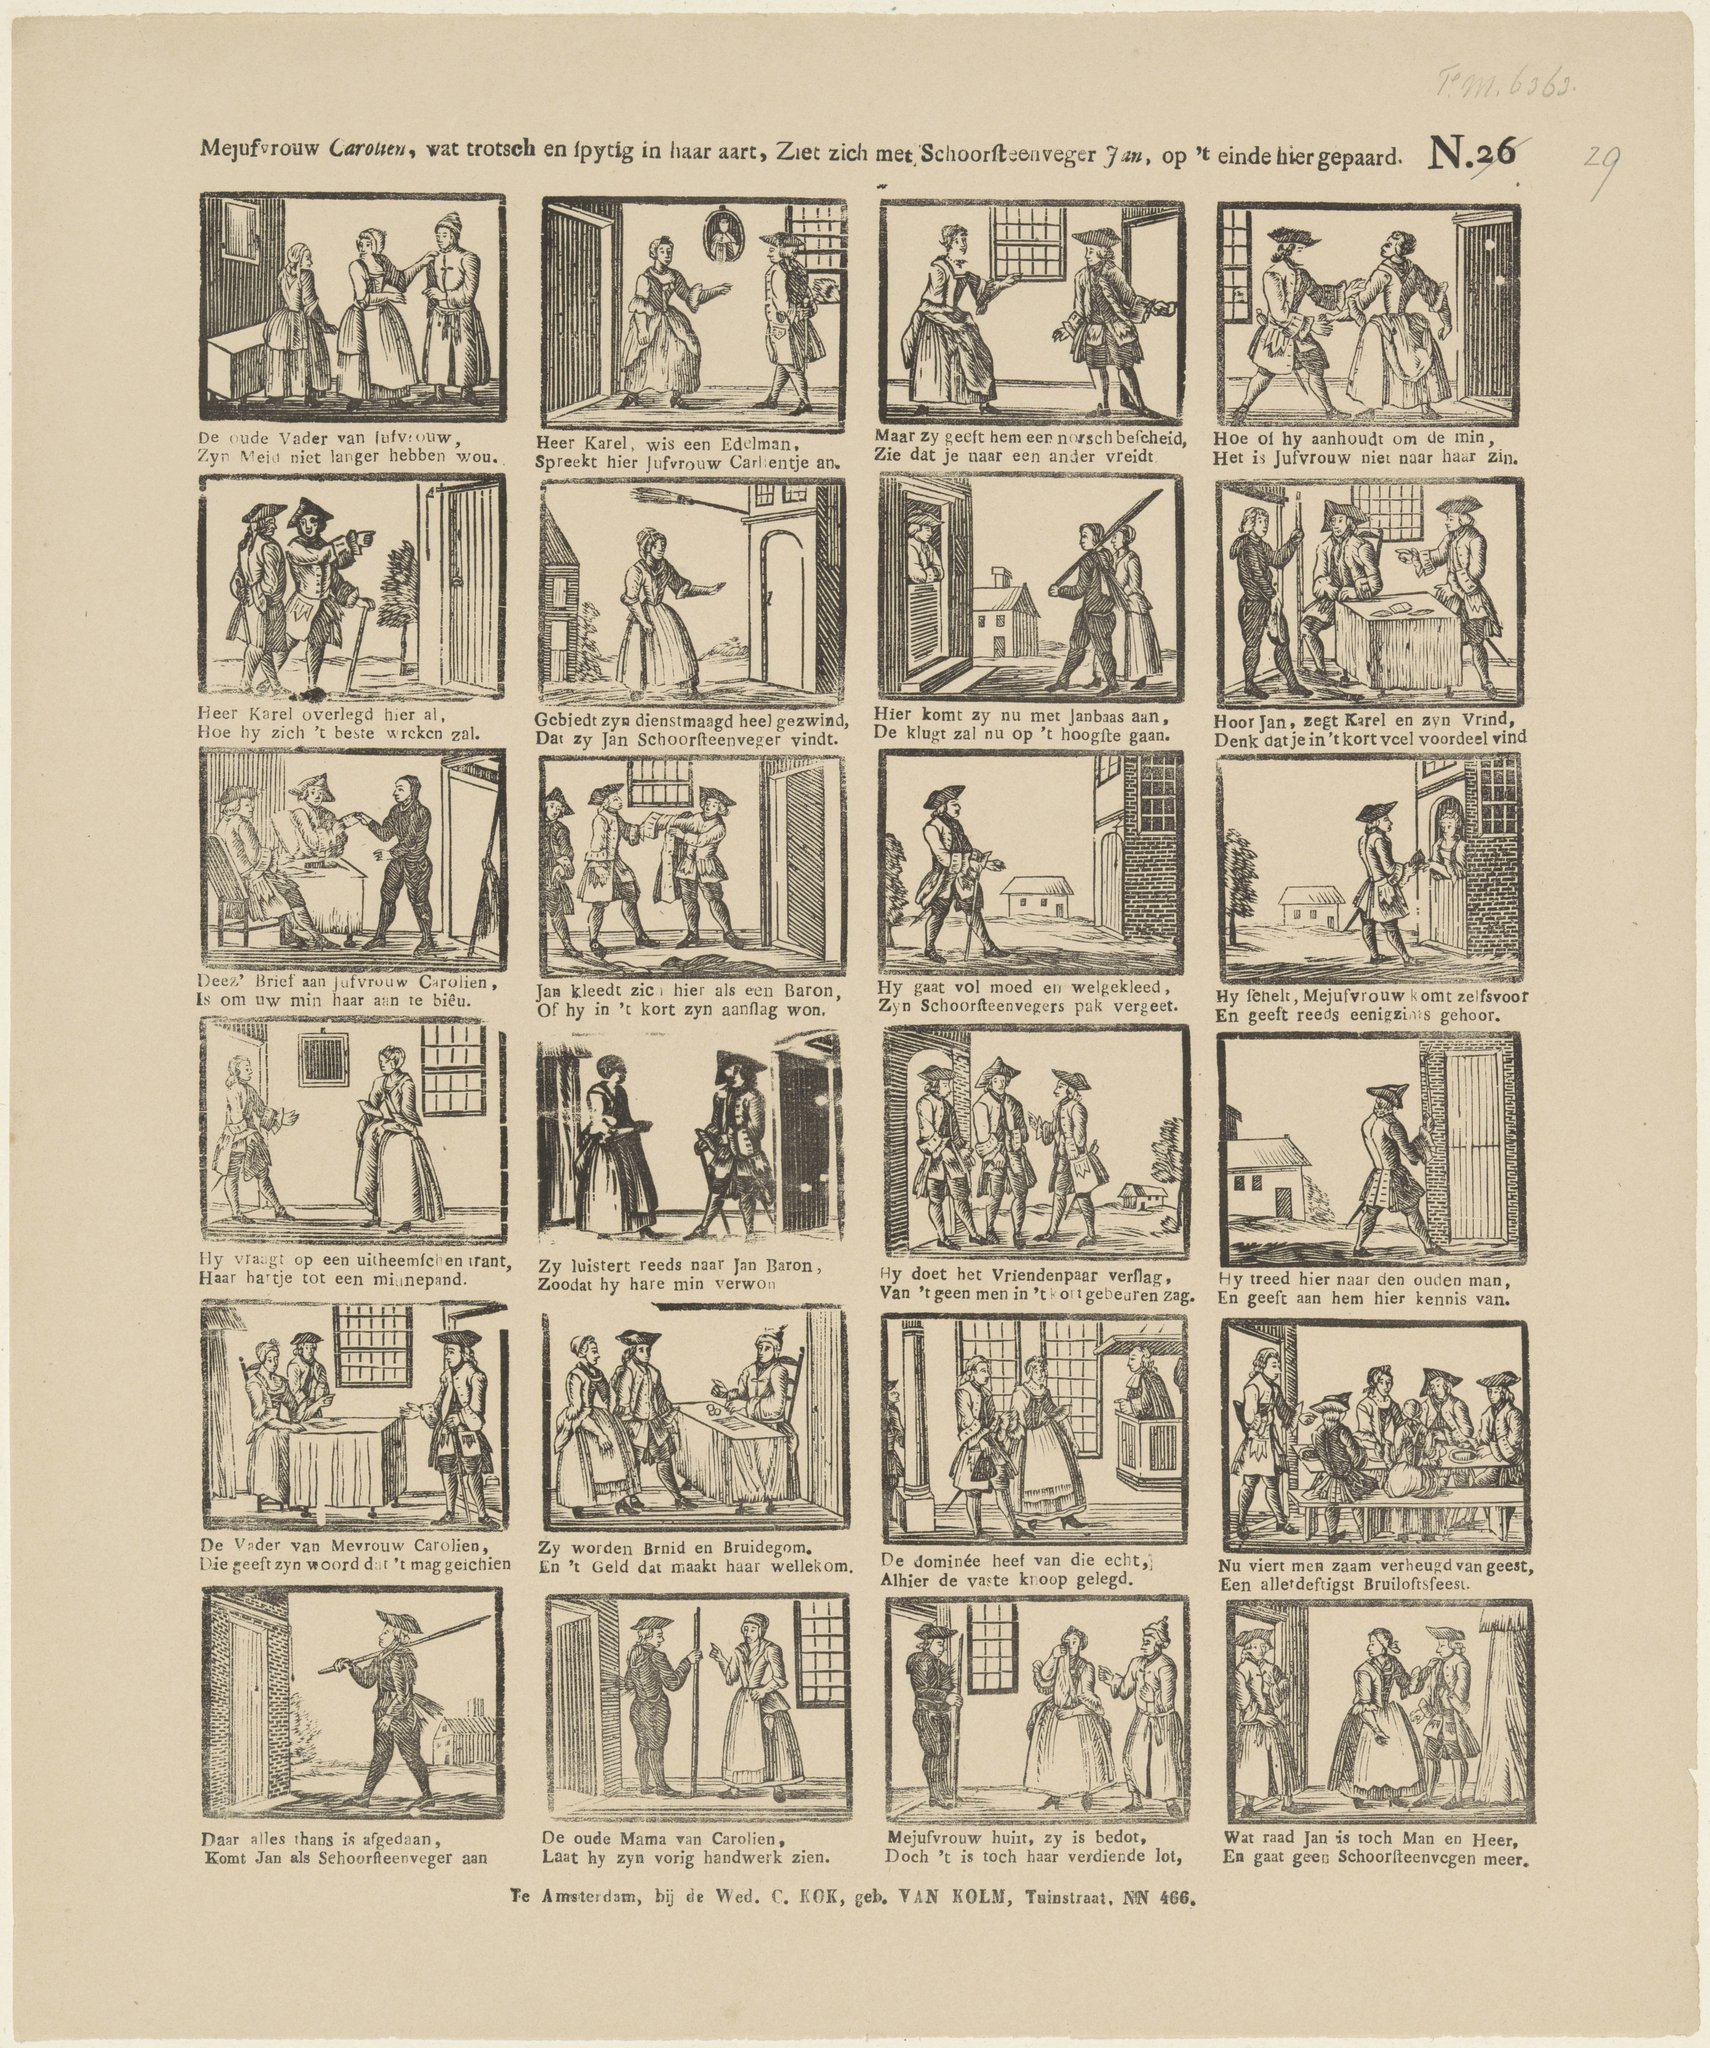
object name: print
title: Mejufvrouw Carolien, wat trotsch en spytig in haar aart, Ziet zich met schoorsteenveger jan, op 't einde hier gepaard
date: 1842-1866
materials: paper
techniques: letterpress printing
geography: amsterdam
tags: handicrafts ~ maintenance and repair (with name of trade or profession), betrothal and marriage, marriage contract, nobility and patriciate; chivalry, knighthood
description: Blad met 24 voorstellingen uit het verhaal van Carolien en schoorsteenveger Jan. Twee afgewezen minnaars van de hoogmoedige Carolien sturen haar een schoorsteenveger die zij rijk hebben uitgedost en goed van geld voorzien. Carolien wordt verliefd en trouwt de vermeende edelman, die daags na het huwelijk zich voordoet voor wat hij werkelijk is. Chrysenia schikt zich in haar lot en kleedt haar man volgens haar rang. Onder elke afbeelding een tweeregelig vers. Genummerd rechtsboven: No. 26 (doorgestreept en verbeterd in 29, in potlood).